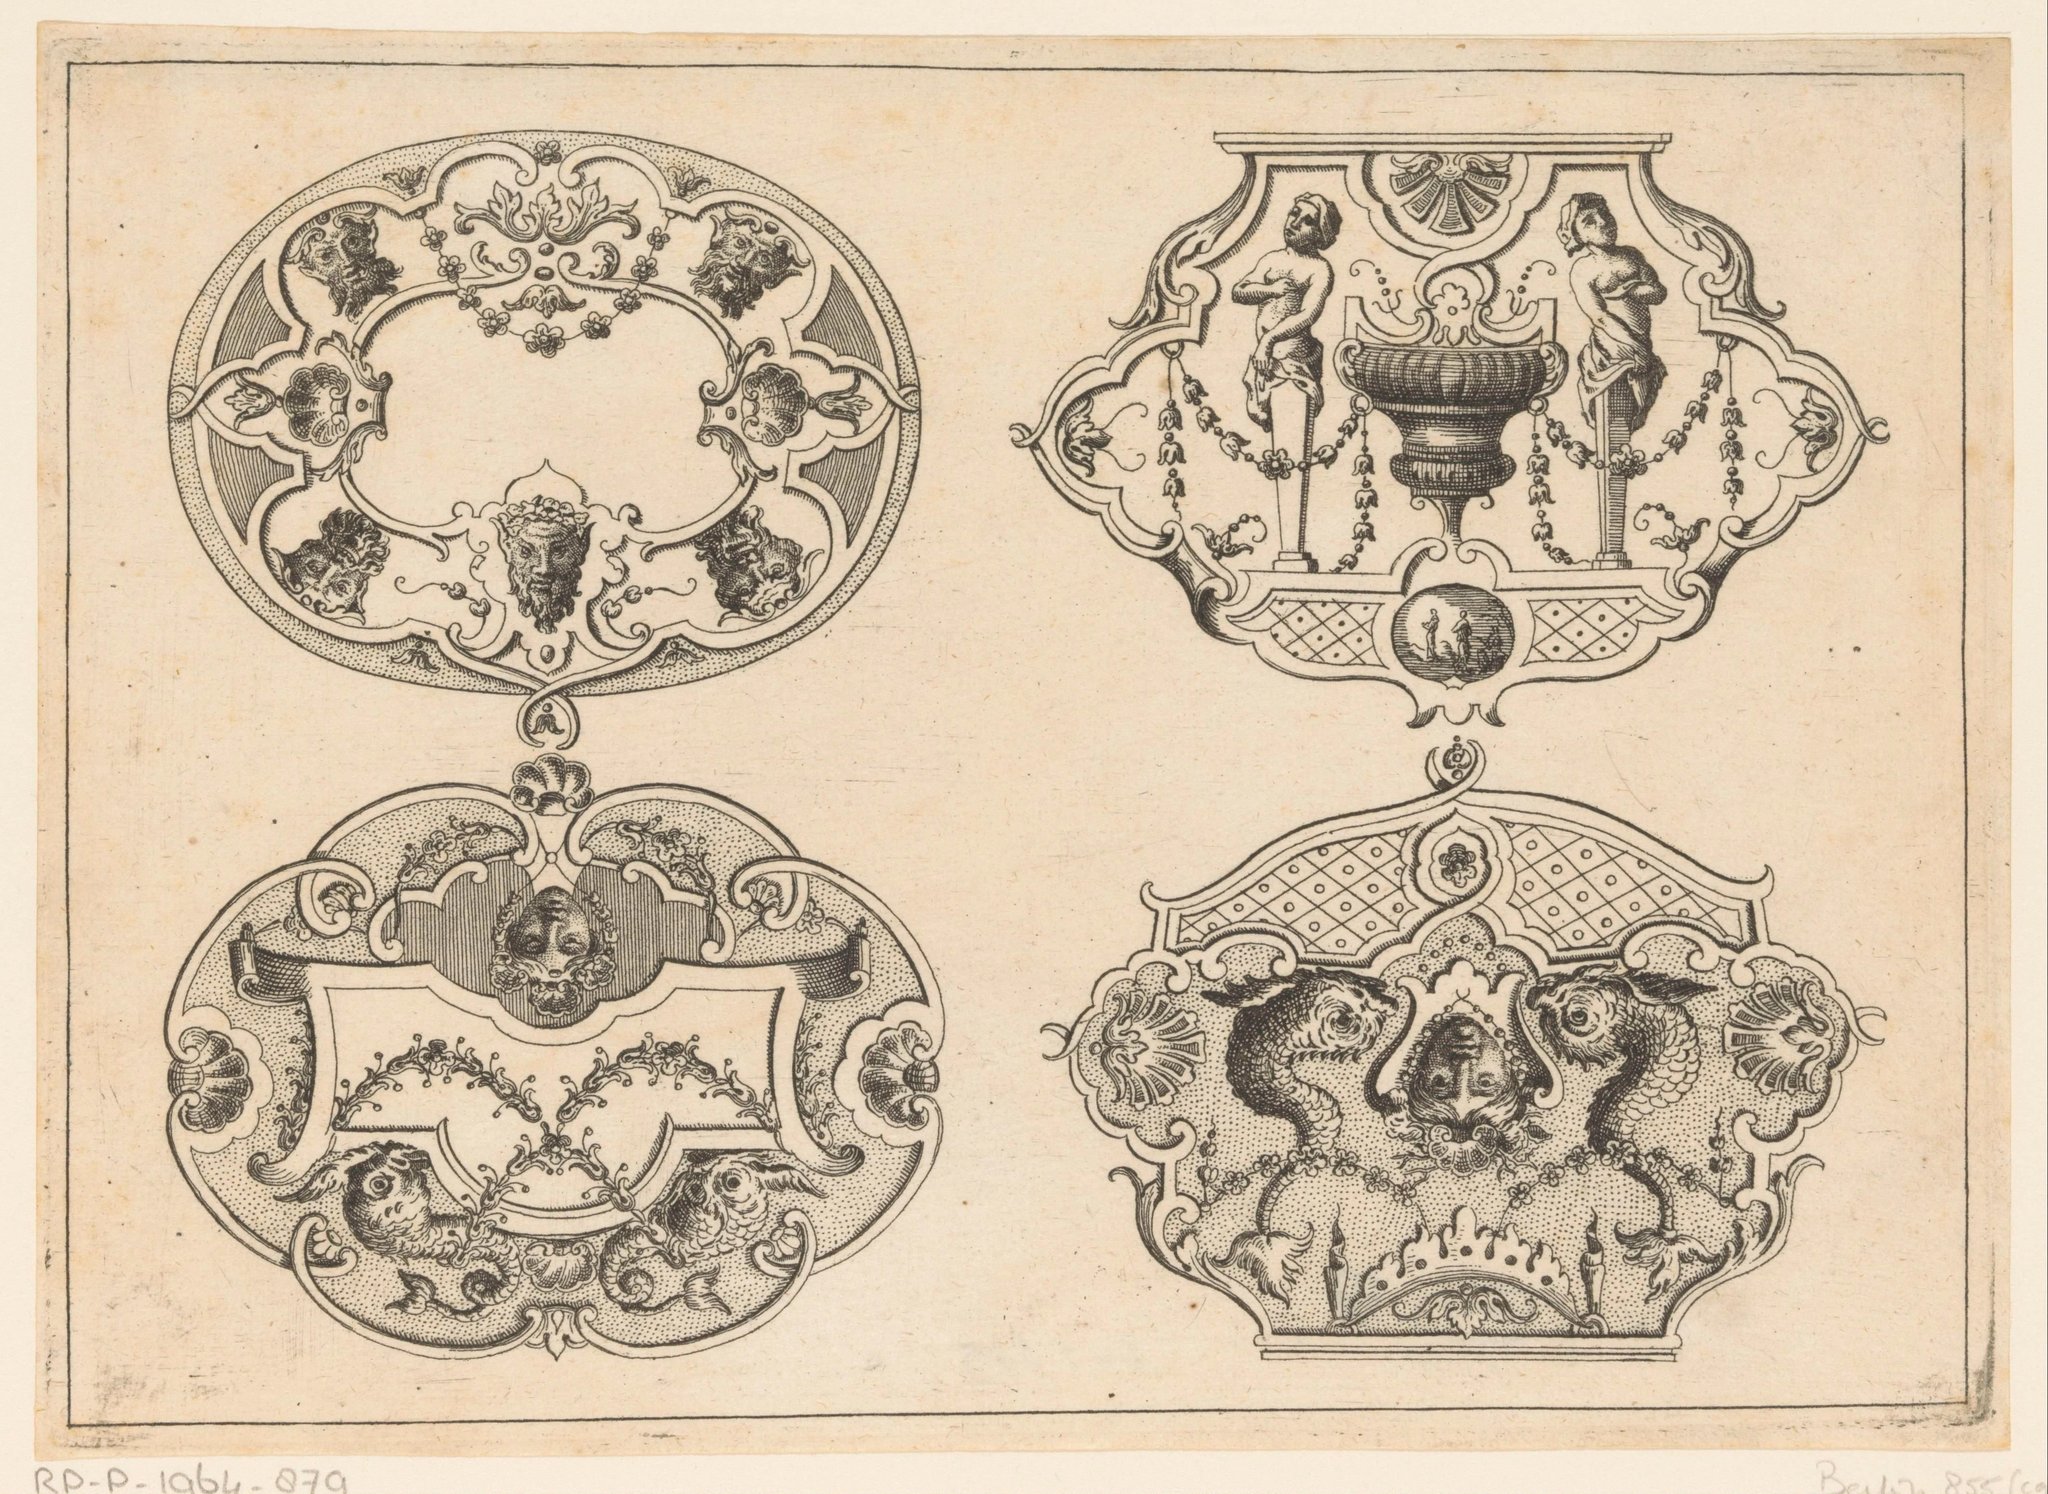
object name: ornament print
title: Deksels met dolfijnen, saterkoppen en vaas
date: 1670-1725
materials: paper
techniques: etching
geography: germany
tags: dolphin ~ ornament, snuff-box, vase ~ ornament, satyr(s) (in general)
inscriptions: collector's mark: Lugt 2760, collector's mark: Lugt 2228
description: Vier deksels van snuifdozen. Links boven met saterkoppen. Rechts boven met termen aan weerszijden van een vaas. Links- en rechts onder met dolfijnen en een masker.